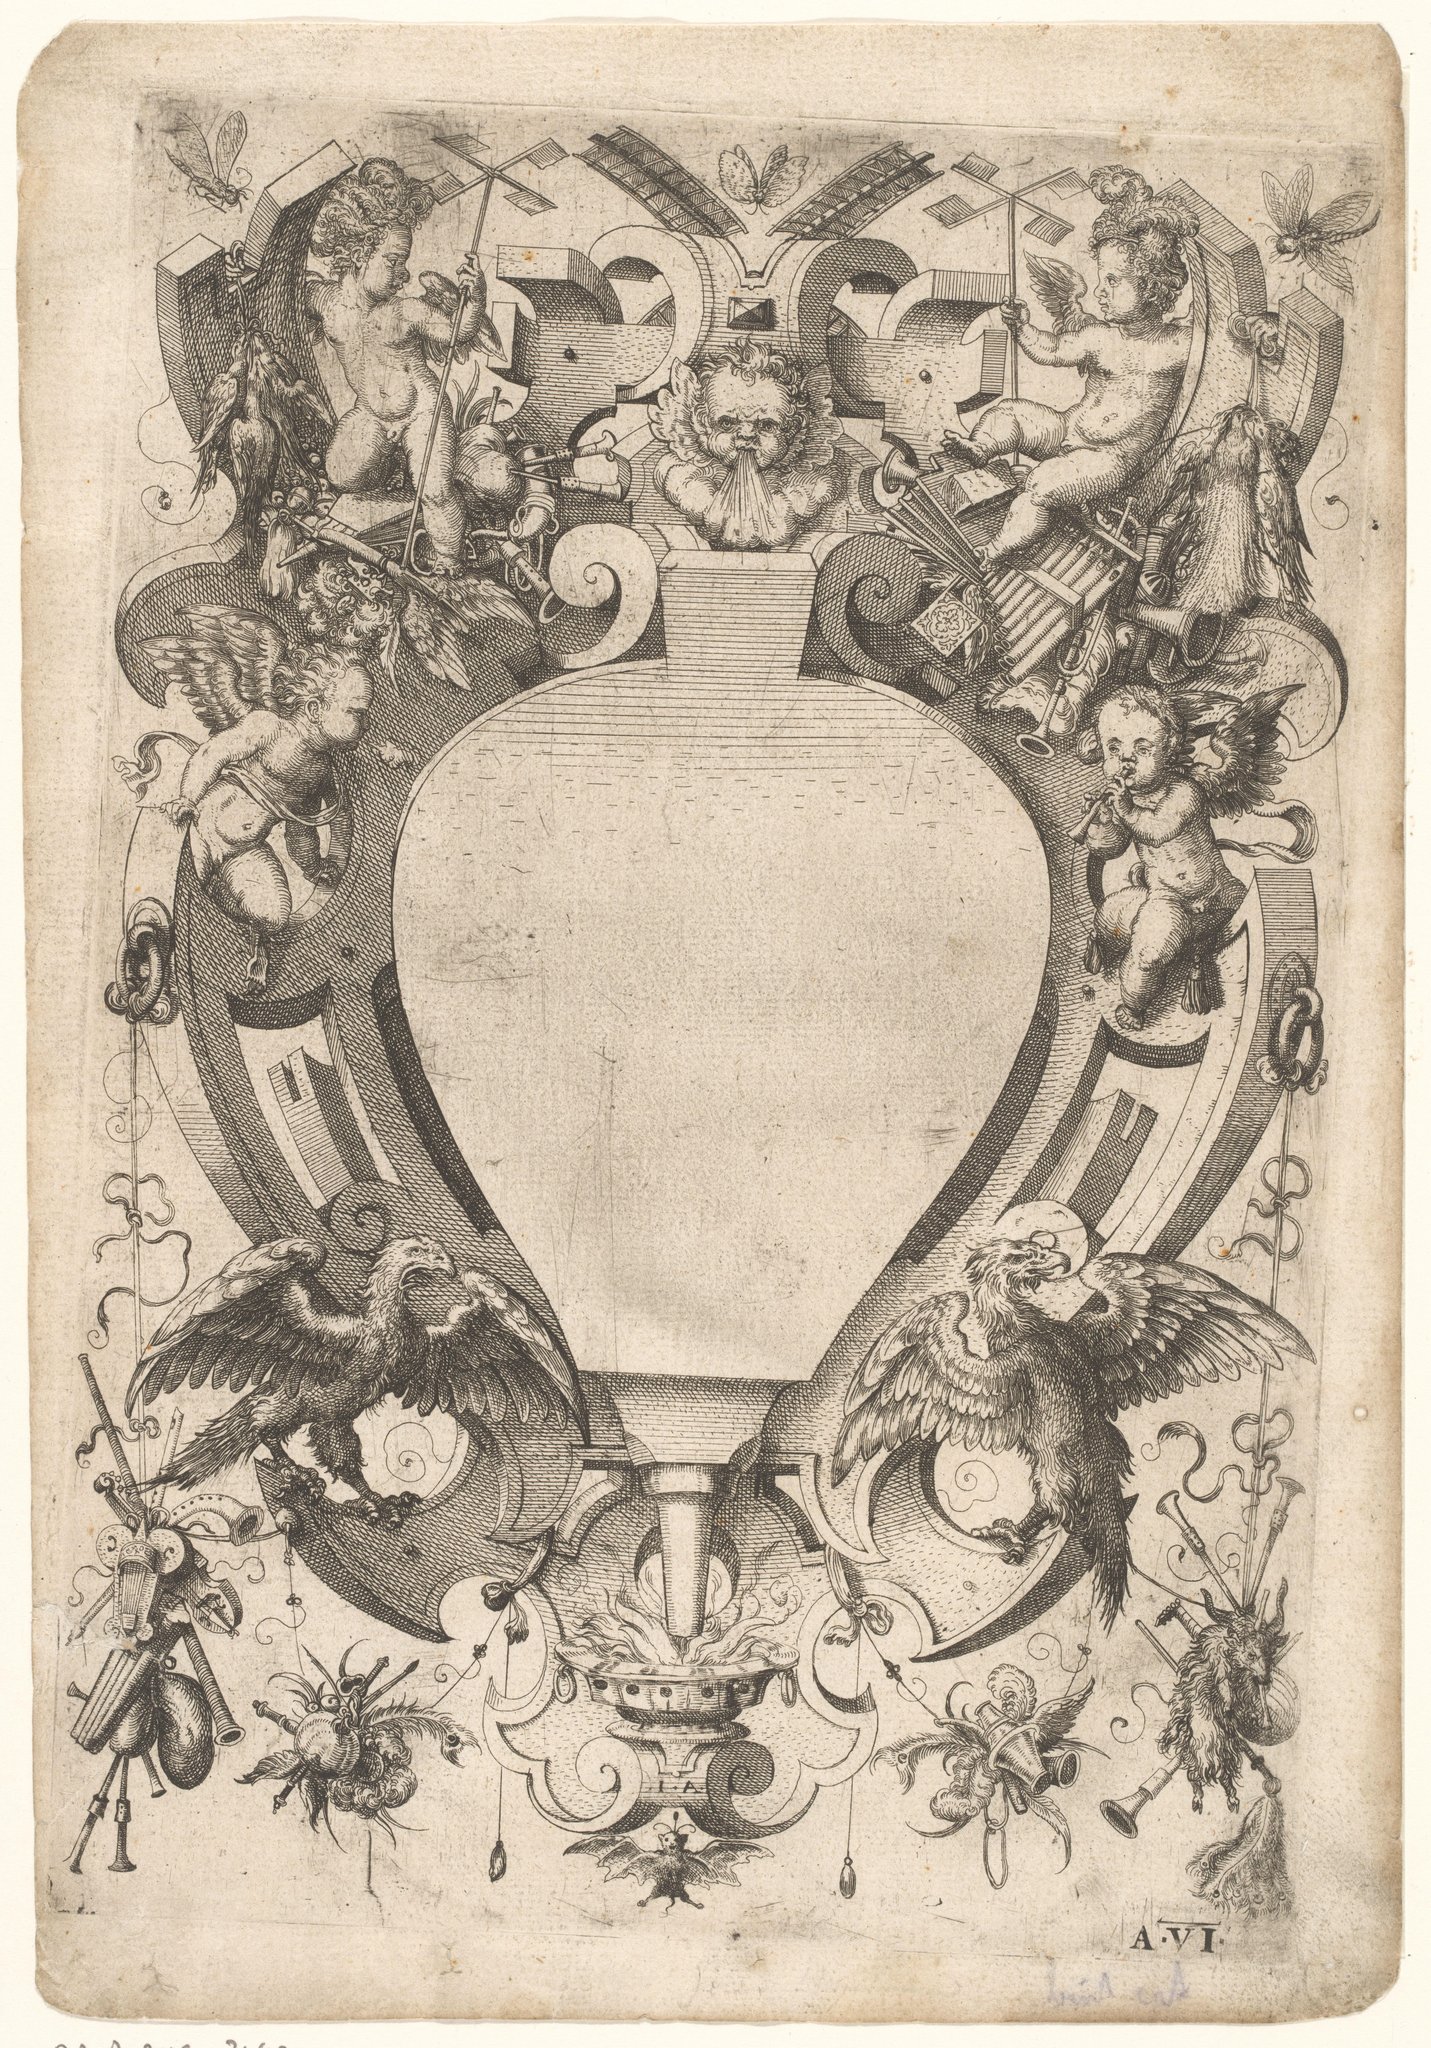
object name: titelblad, titelpagina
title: Aer / Der Lufft / Octaedron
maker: jost amman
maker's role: draughtsman, painter, print maker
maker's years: 1539-1591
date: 1568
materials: paper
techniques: engraving, etching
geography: nuremberg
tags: wind as a human face, blowing with rounded cheeks, (playing with) revolving toys, (playing with) toys ~ air, air (one of the four elements), birds, winds, wind instruments, bellows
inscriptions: number: ‘A.VI’, collector's mark: Lugt 2760, signature: ‘I.A.’, collector's mark: Lugt 2228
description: Centraal een blaasbalg in een omlijsting met rolwerk versierd met roofvogels, kinderen met molentjes zittend op blaasbalgen, een blazend kind , een windkopje en een fluitspelend kind. Bovenaan insecten en trofeeën met dode gevangen vogels. Onderaan hangende trofeeën met windinstrumenten zoals doedelzakken. Proefdruk zonder tekst van een titelpagina in Wenzel Jamnitzer, Perspectiva corporum regularium.